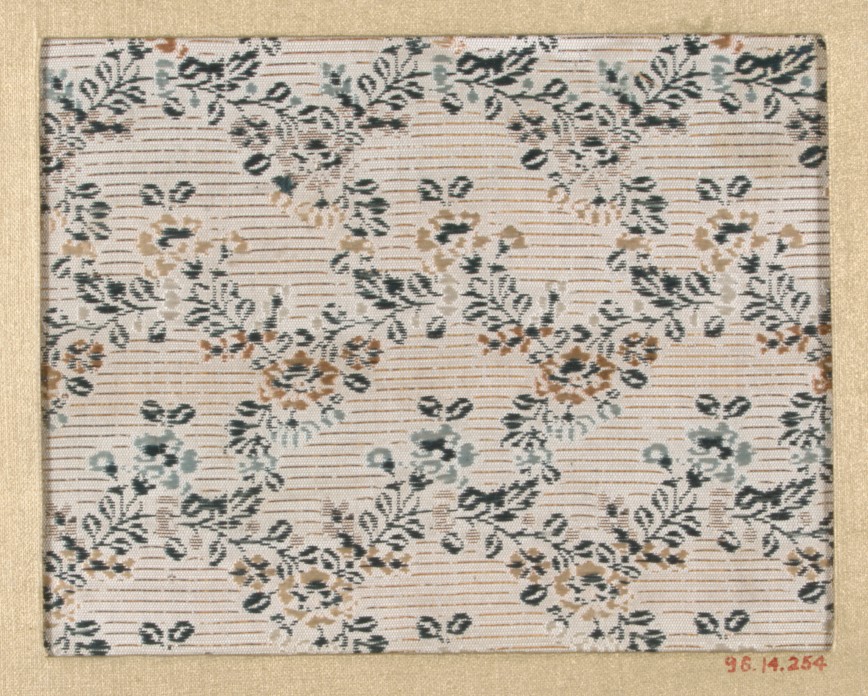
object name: piece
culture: japanese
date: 1701-1900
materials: silk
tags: leaves